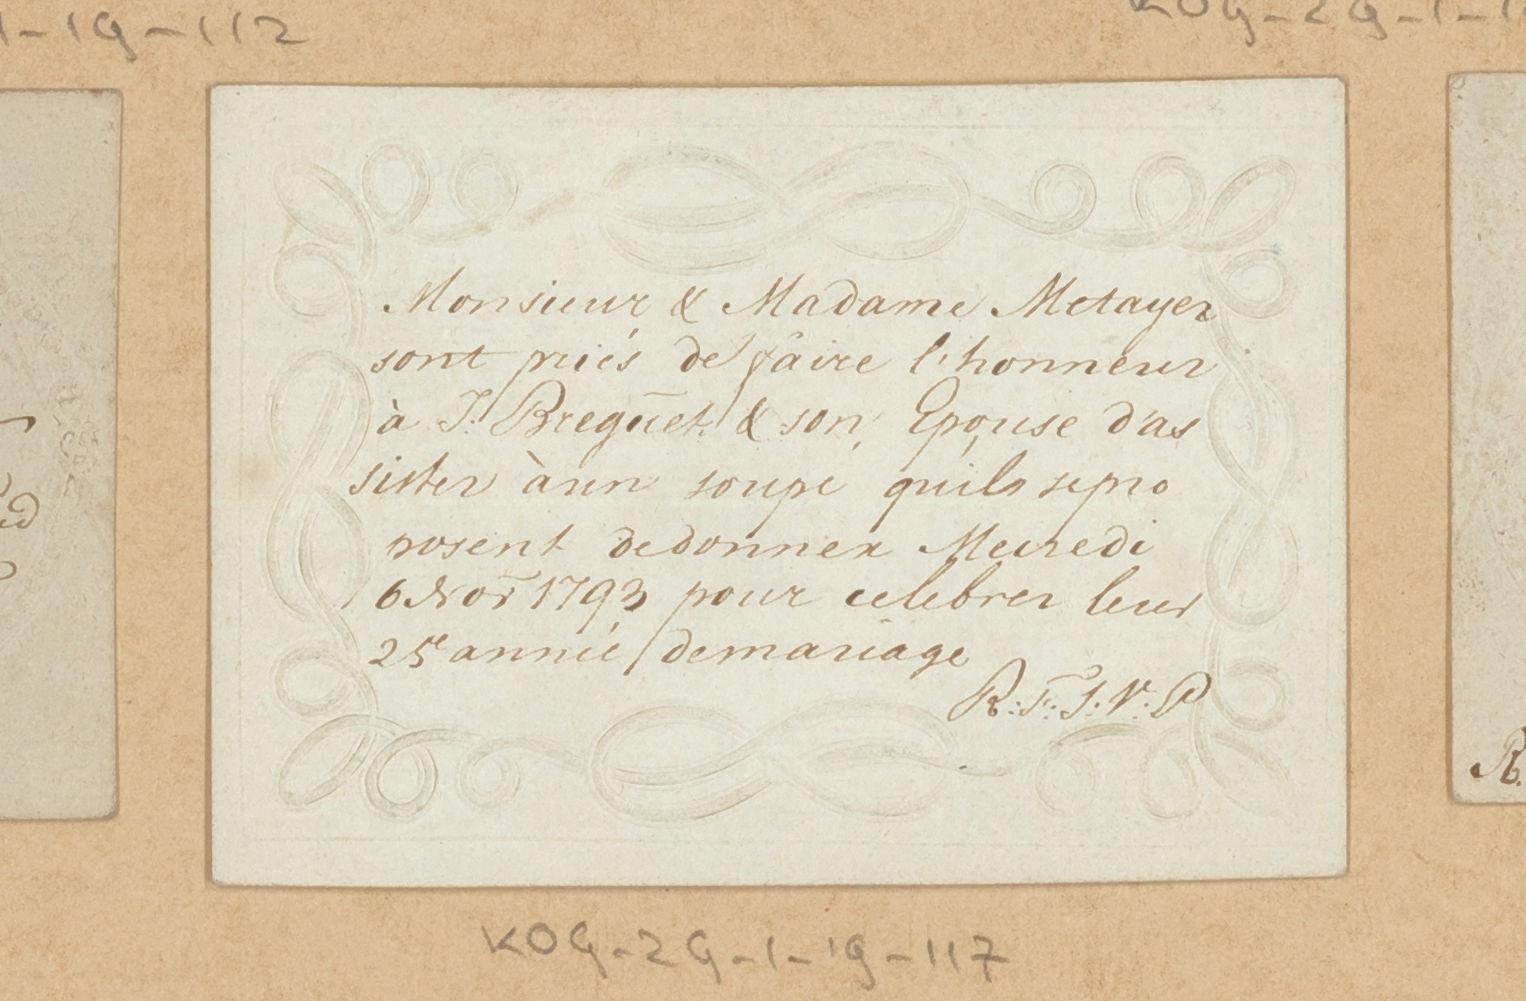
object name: print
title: Uitnodiging aan Monsieur & Madame Metayer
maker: j. breguet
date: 1711-1793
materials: paper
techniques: blind stamped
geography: amsterdam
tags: louis metayer phzn., antoinette bernard, j. breguet, silver anniversary, letter, envelope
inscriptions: collector's mark, collector's mark: Lugt 1641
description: Kaartje met een handgeschreven uitnodiging en RSVP aan monsieur en madame Metayer, voor een souper ter gelegenheid van het 25-jarig huwelijksjubileum van J. Breguet en zijn vrouw, op 6 november 1793. Onderdeel van een groep van bruilofts- en invitatiekaartjes van de families Bernard en Metayer. Onderwerpsrubrieken binnen de Atlas Zeden en Gewoonten: Des Menschen Begin, Midden en Einde. Bruiloft en huwelijk.